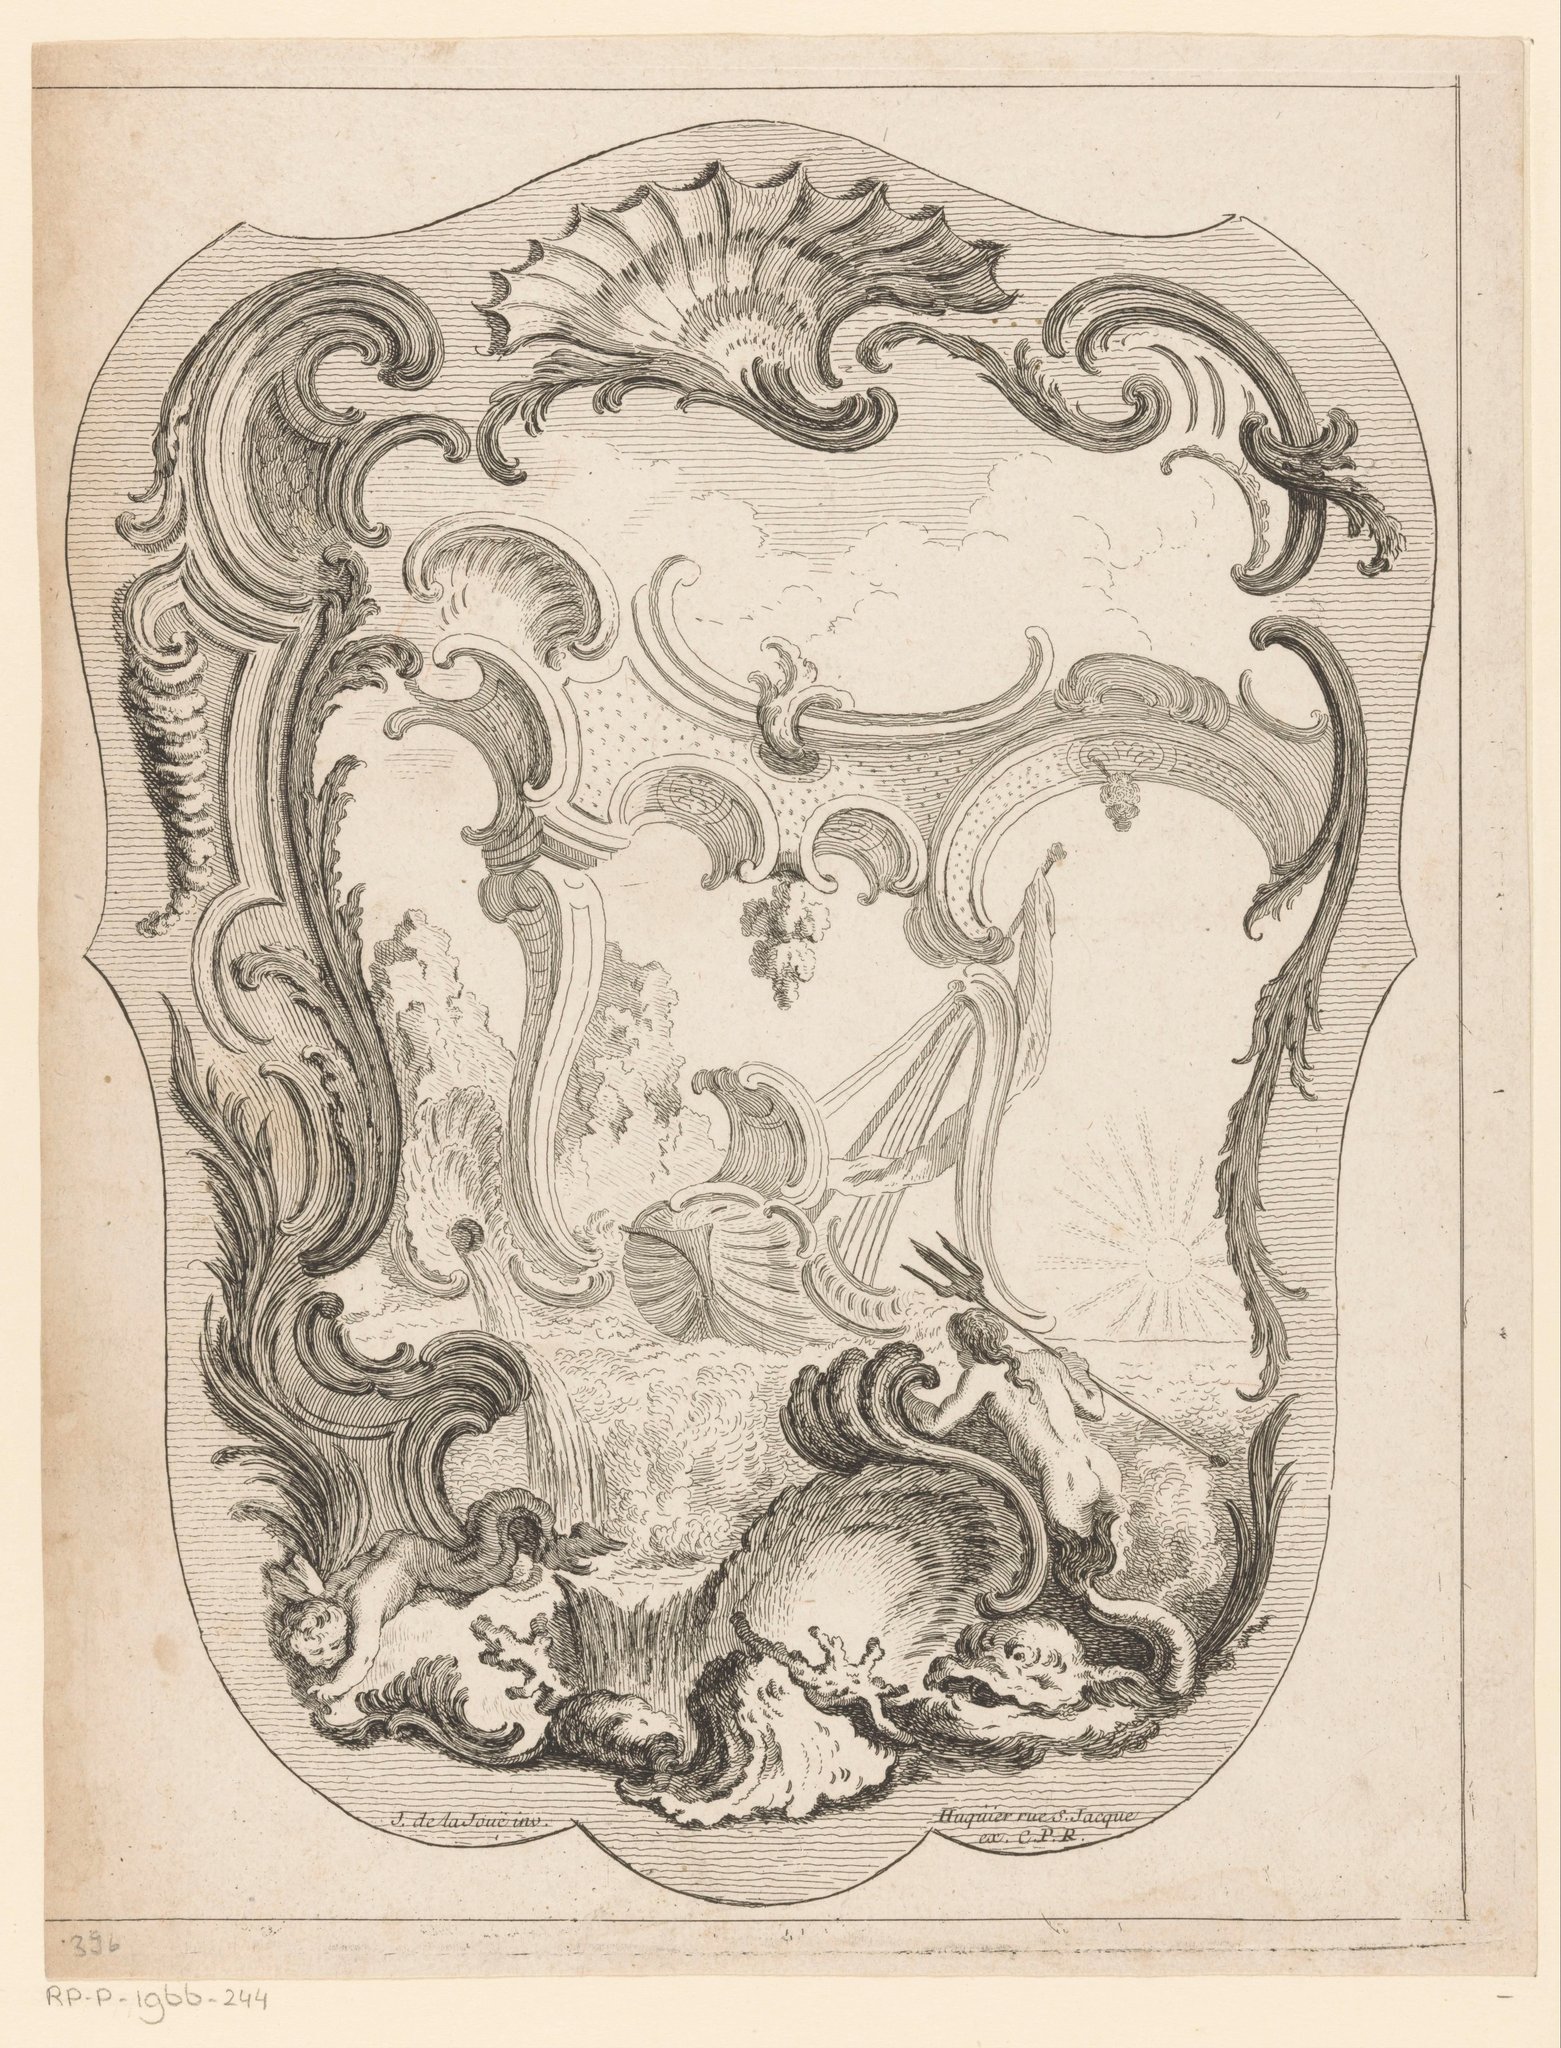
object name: print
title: Aangemeerd schip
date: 1738-1749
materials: paper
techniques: etching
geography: paris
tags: ships (in general)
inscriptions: collector's mark: Lugt 2228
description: Een schip aangemeerd aan land, rechts de zon. Rondom een rocaille omlijsting met een naakte figuur met drietand, een dolfijn en een putto met vissenstaart.